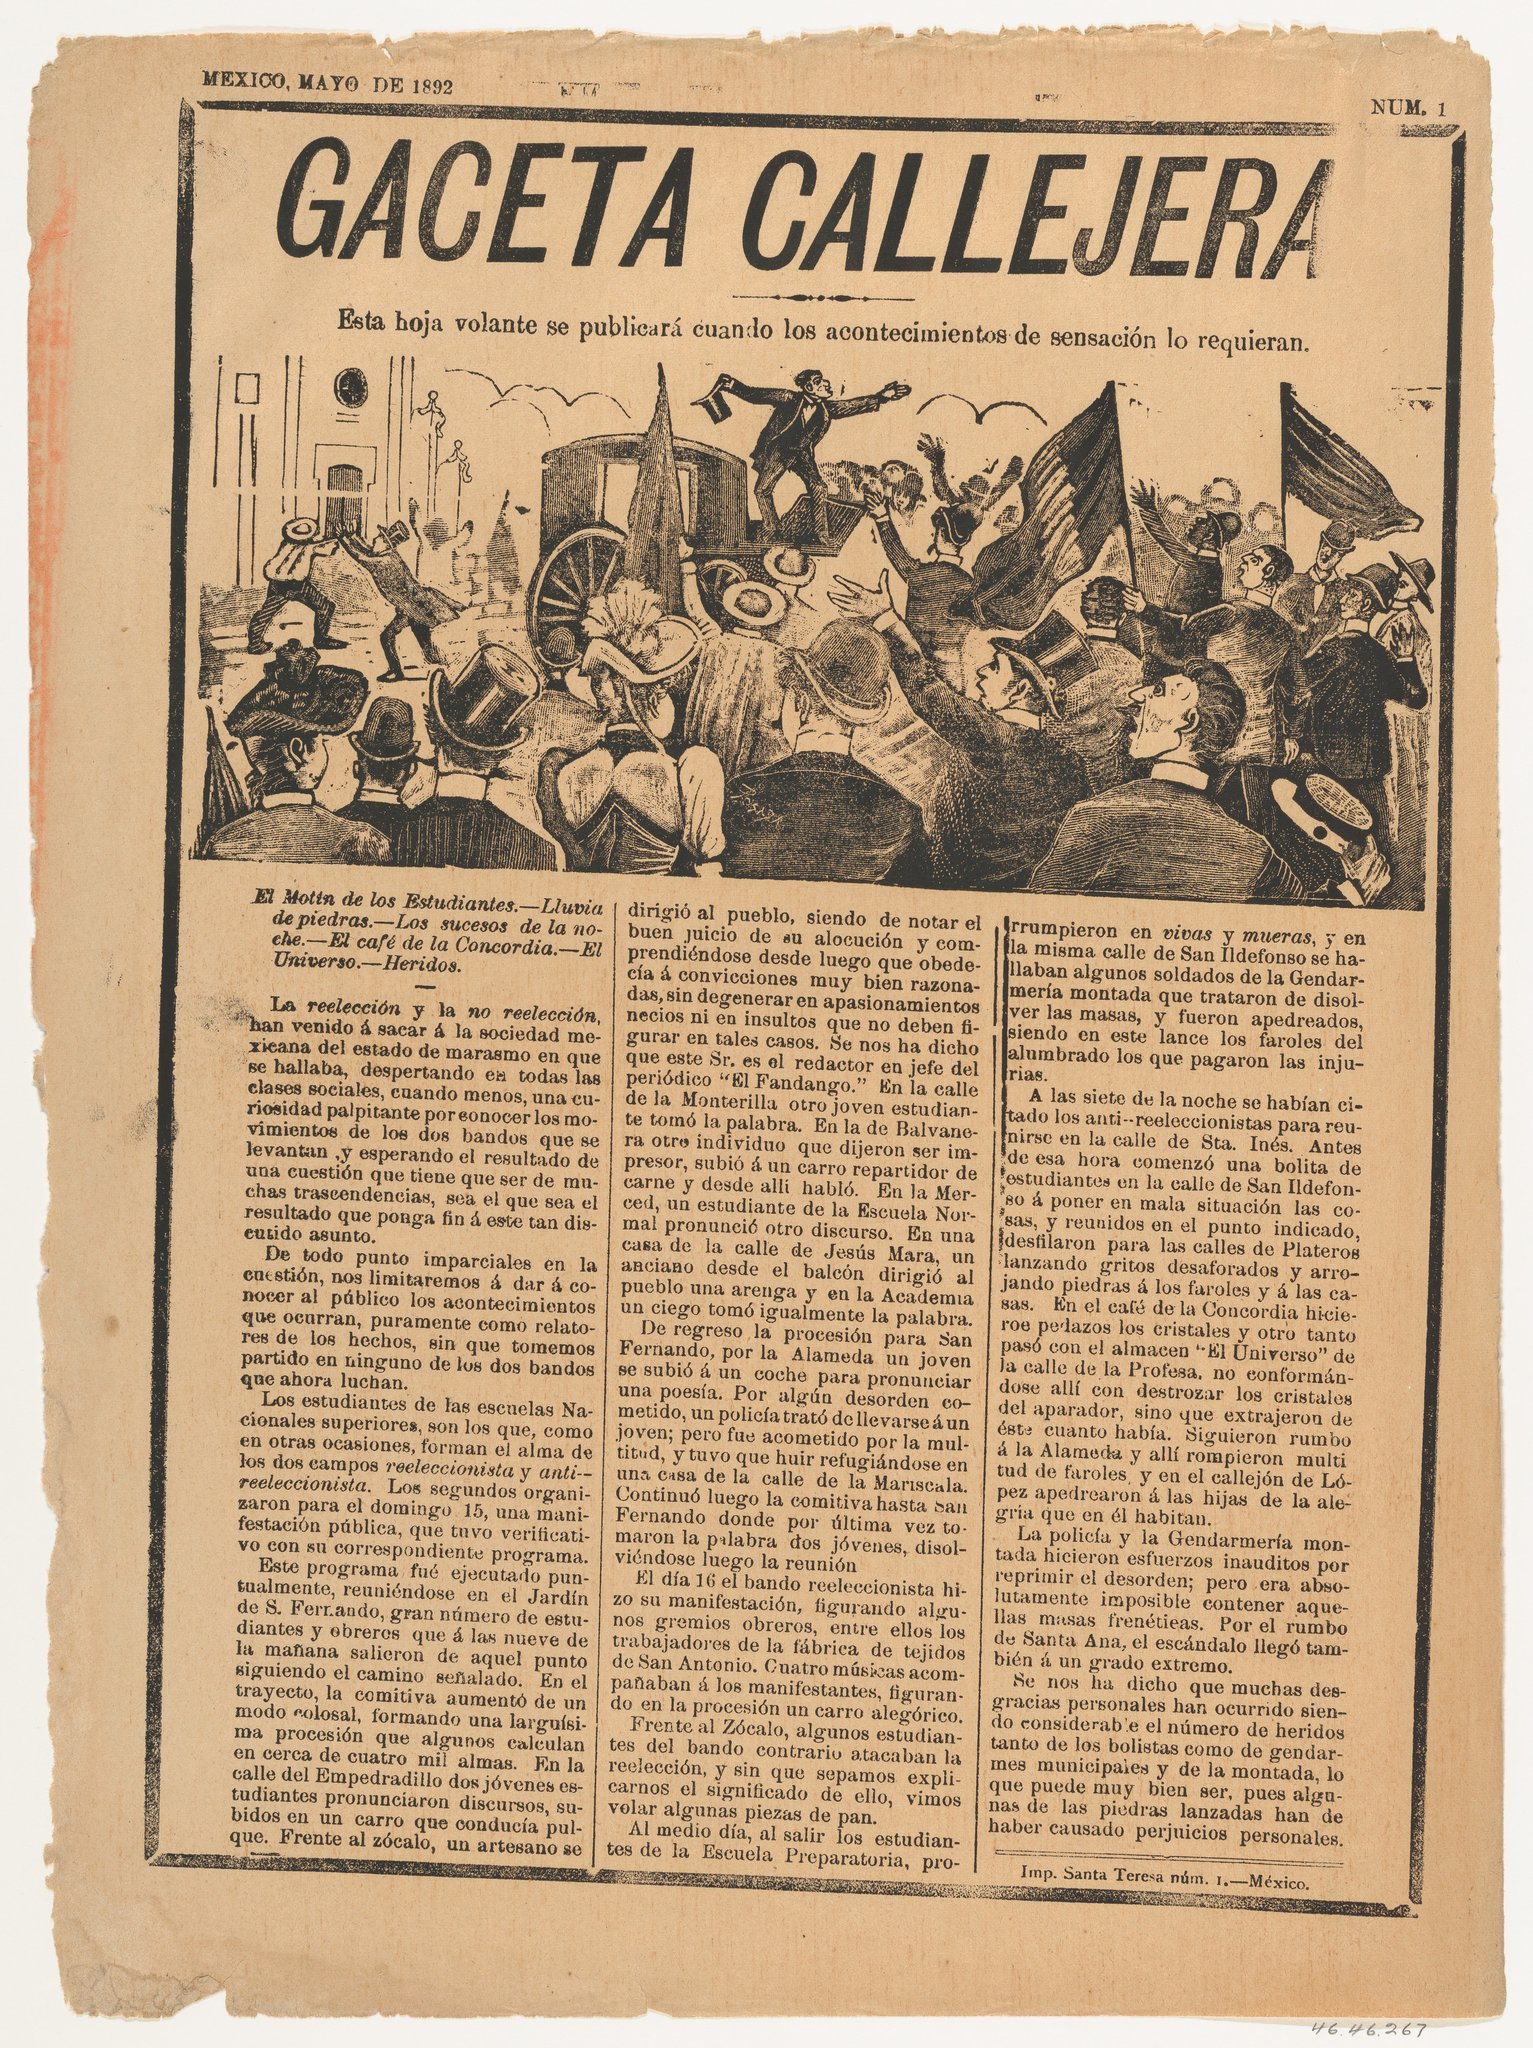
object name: print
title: Page from the 'Gaceta Callejera' relating to the continuation of anti re-election riots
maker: josé guadalupe posada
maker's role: artist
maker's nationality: mexican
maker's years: 1852-1913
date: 1892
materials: metal, paper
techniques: engraving, letterpress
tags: crowd